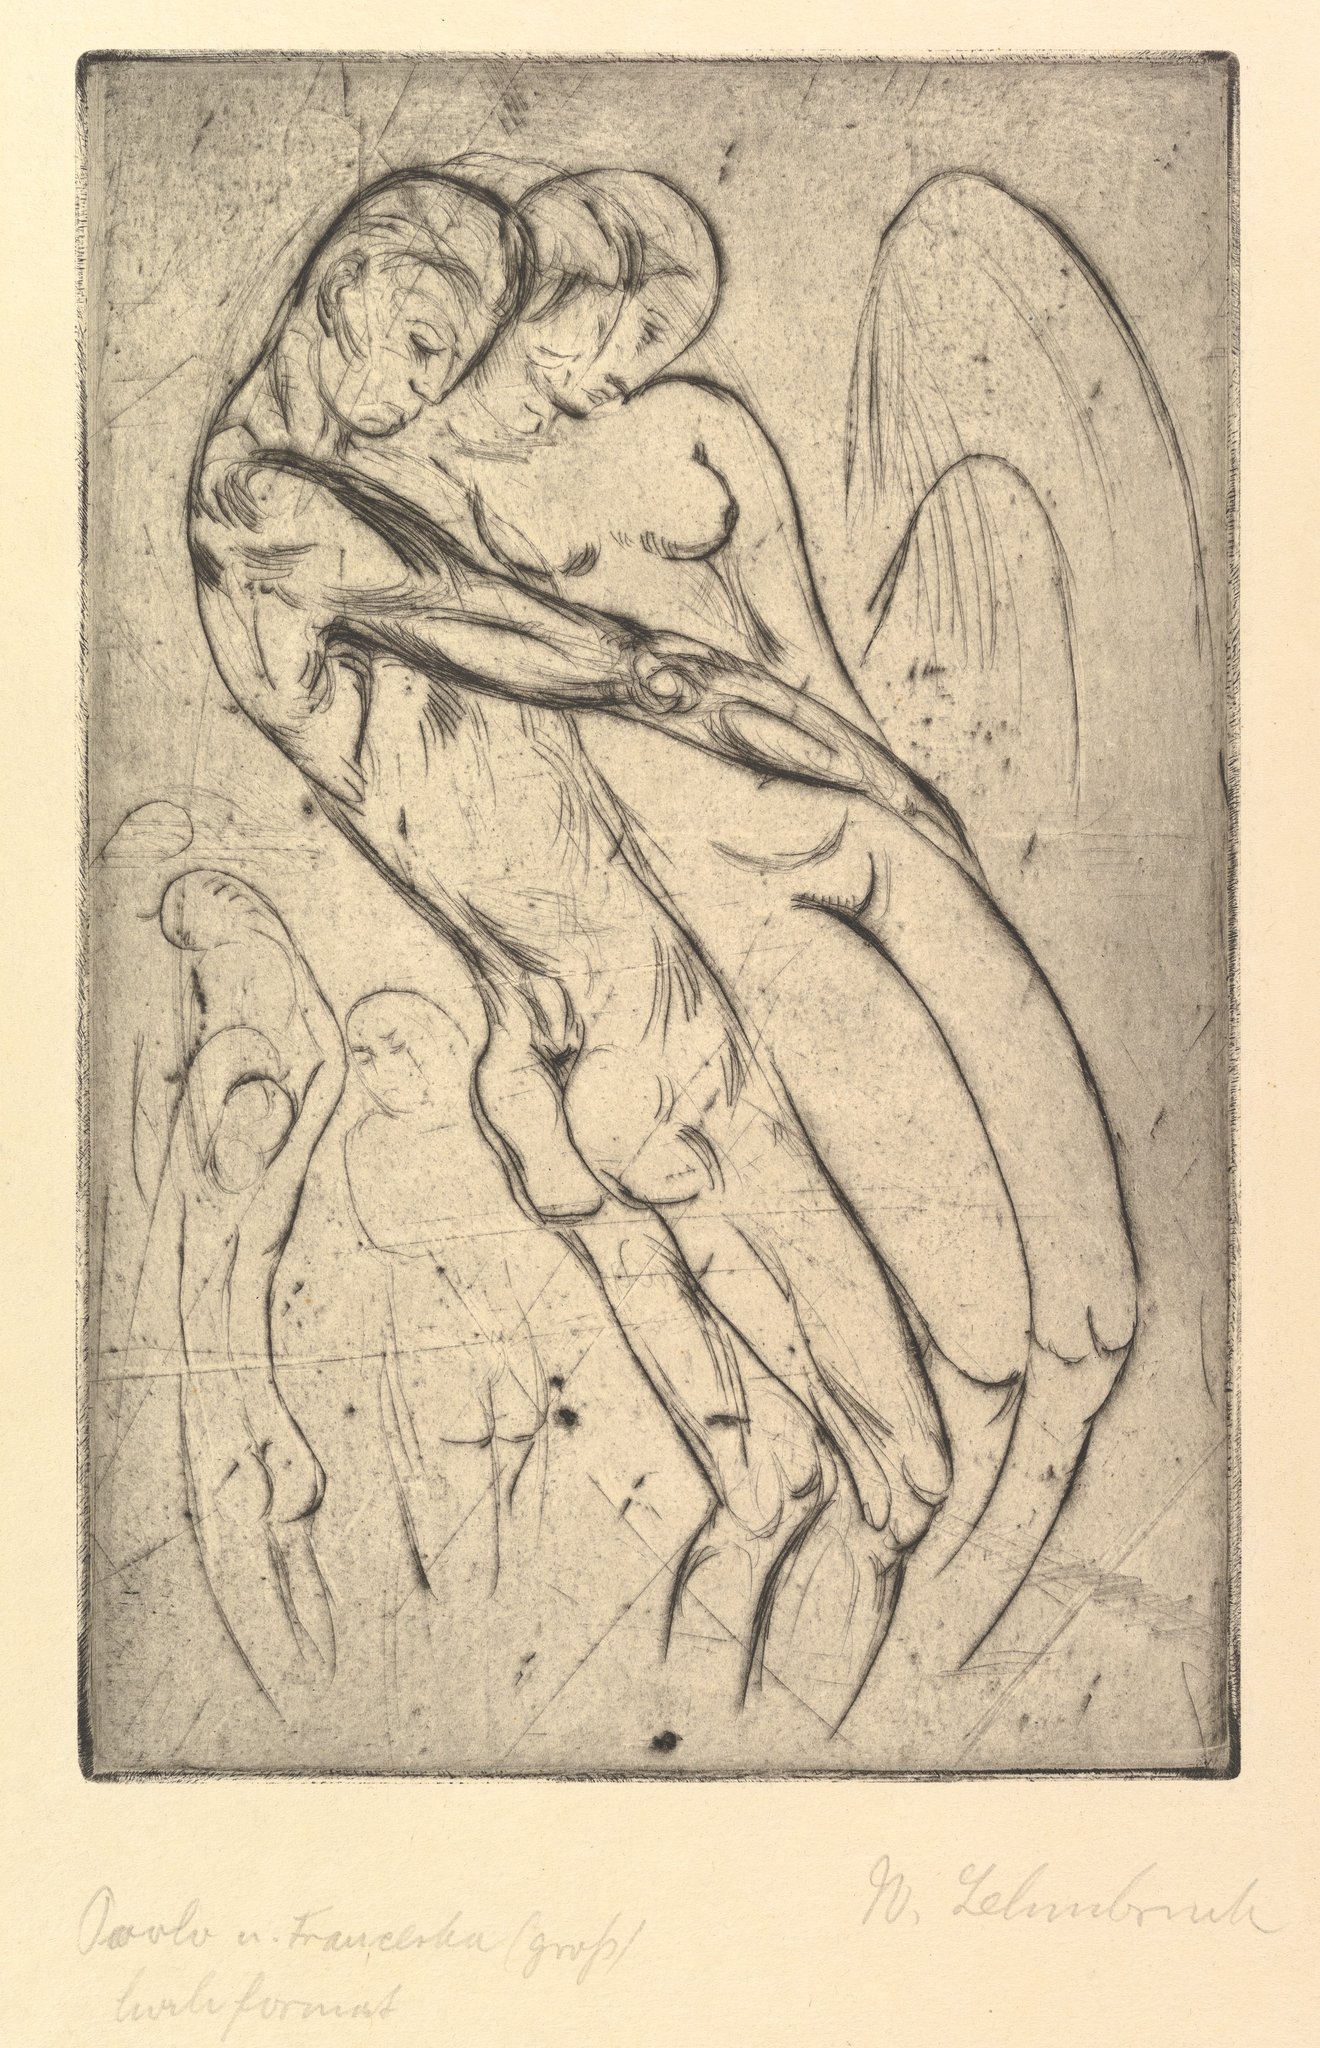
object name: print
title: Paolo and Francesca (Paolo und Francesca groß, Hochformat)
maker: wilhelm lehmbruck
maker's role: artist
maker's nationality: german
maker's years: 1881-1919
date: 1913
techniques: drypoint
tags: male nudes,female nudes